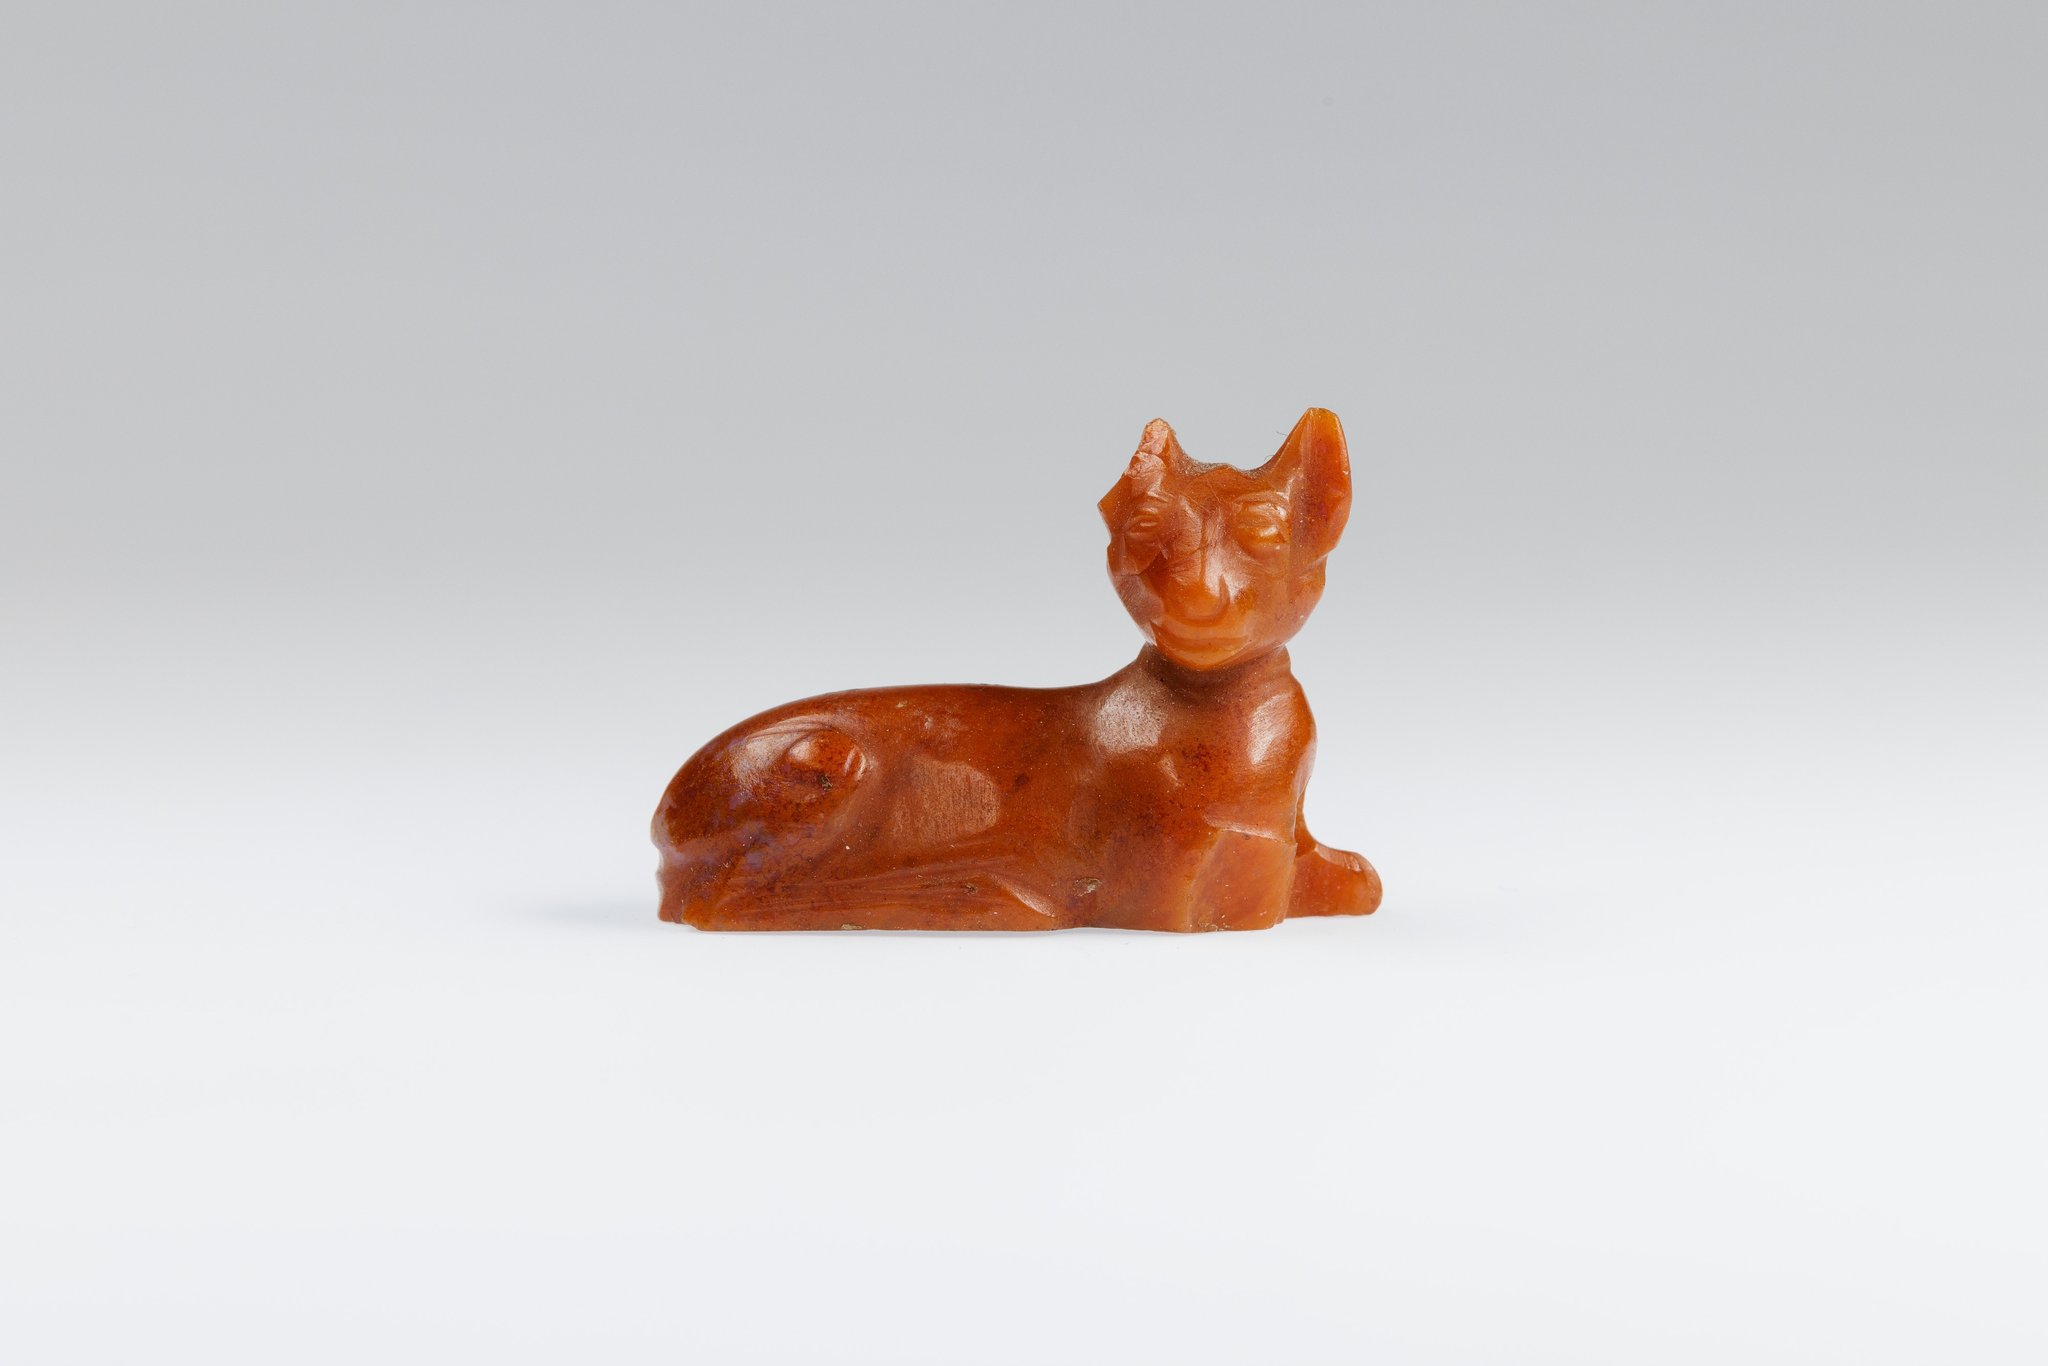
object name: amulet, cat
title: Cat amulet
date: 664-630 BCE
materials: gemstone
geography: egypt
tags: cats